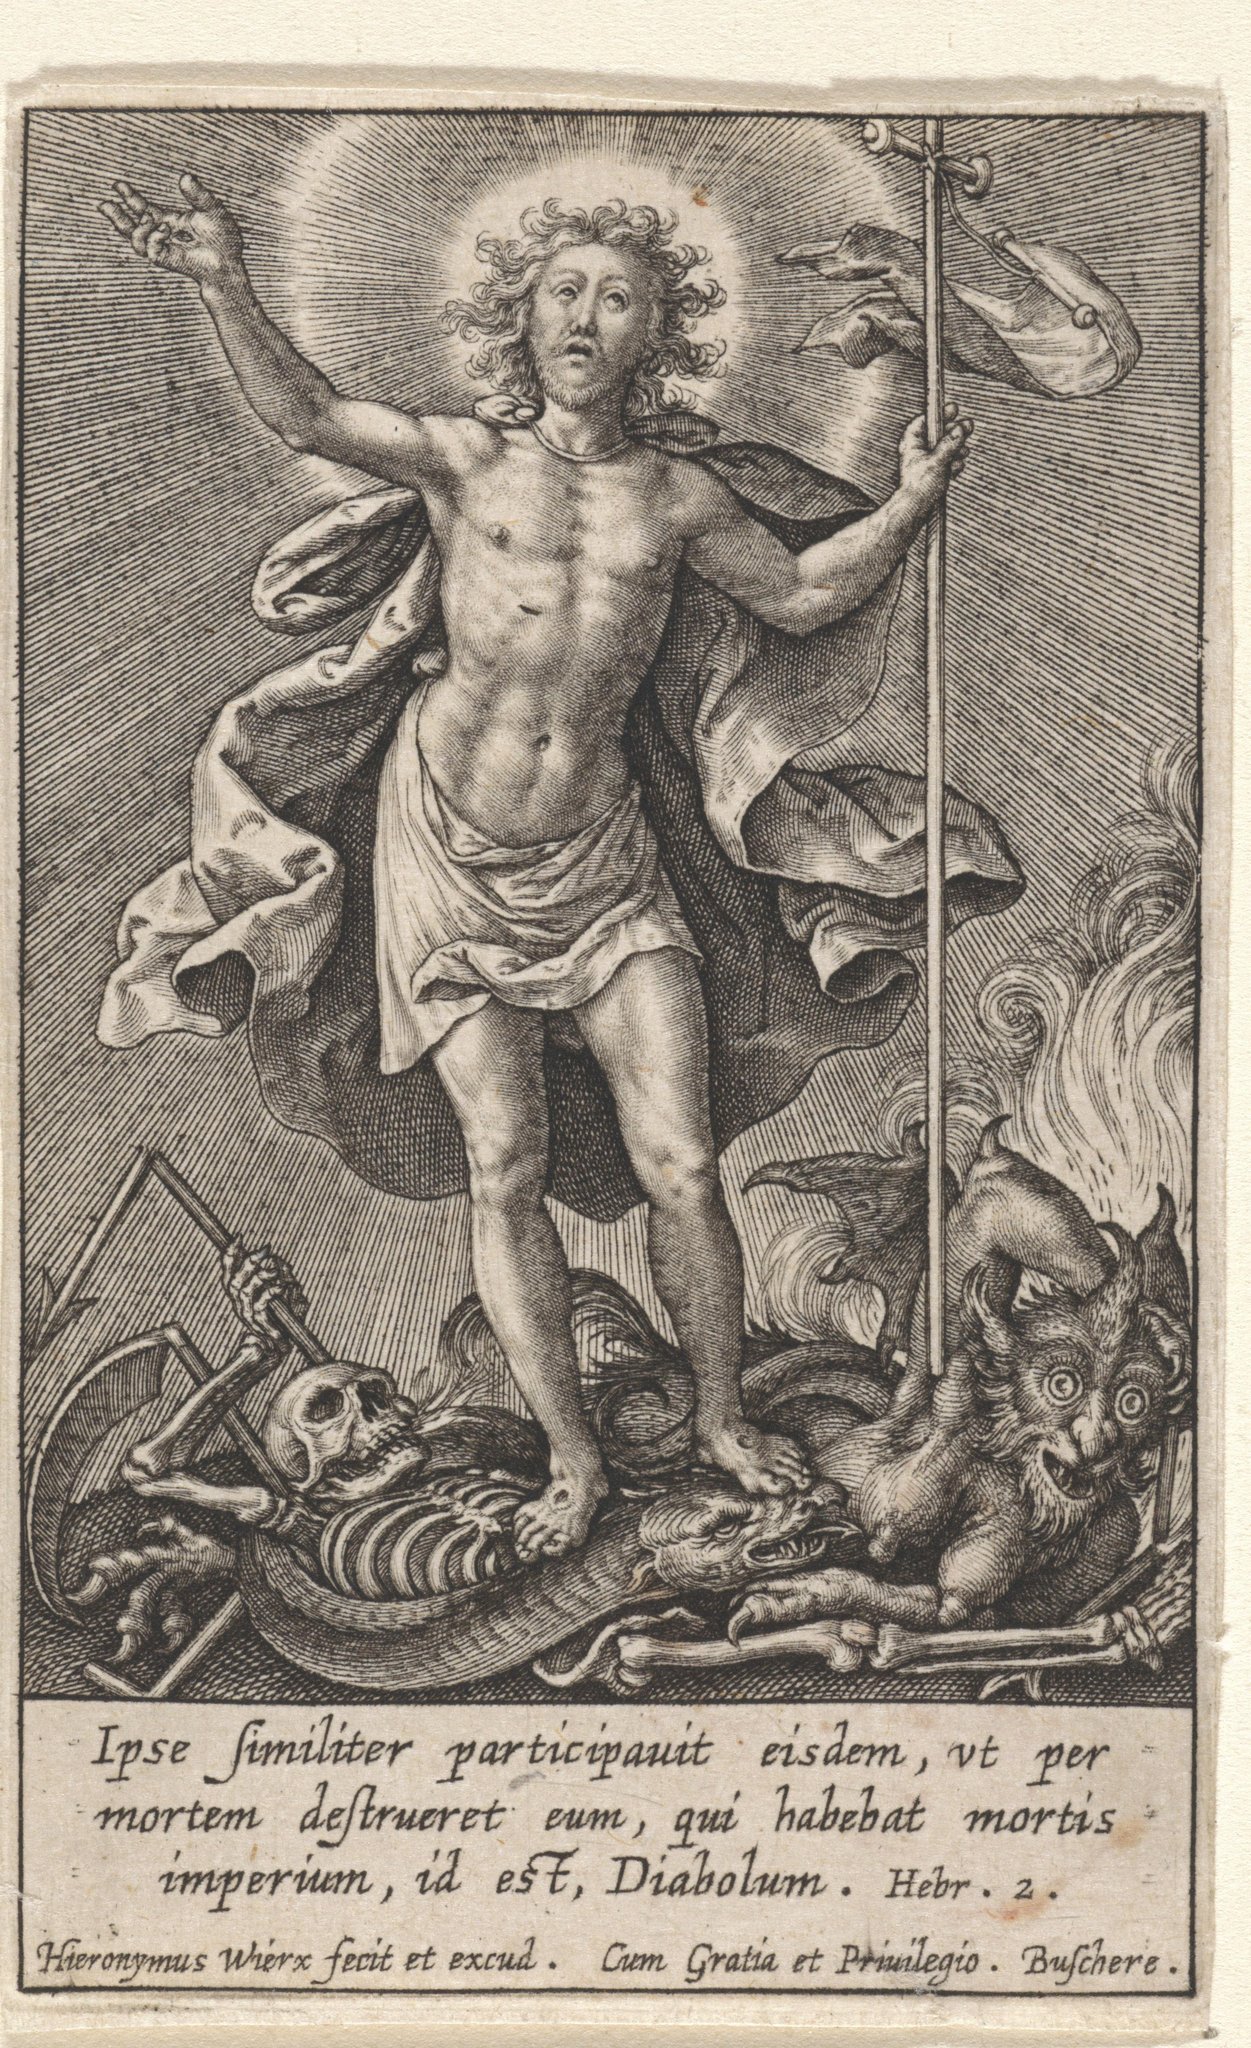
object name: print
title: Passie van Christus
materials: paper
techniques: engraving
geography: antwerp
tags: death as skeleton, christ triumphing (with crown, head usually upright), christ triumphing over devil(s)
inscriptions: collector's mark: Lugt 240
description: De triomferende Christus overwint de Dood en de duivel. In de marge een drieregelig Bijbelcitaat uit Heb. 2 in het Latijn.